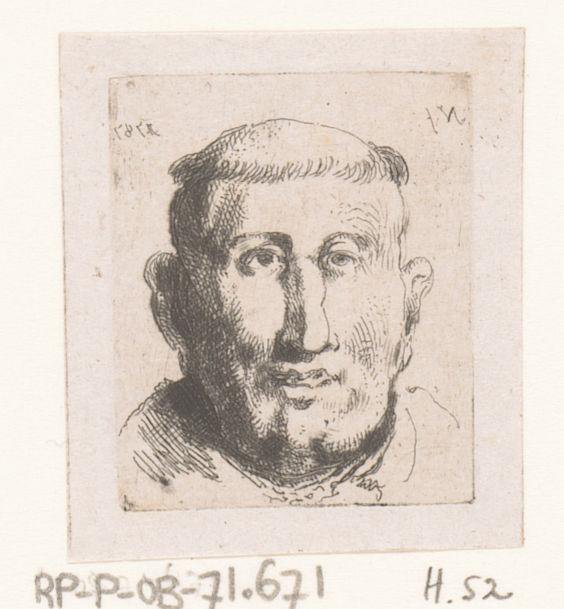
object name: print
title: Kop van een monnik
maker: jean pierre norblin de la gourdaine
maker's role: print maker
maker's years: 1745-1830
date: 1787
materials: paper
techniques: etching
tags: head (human), monk(s), friar(s)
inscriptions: collector's mark: Lugt 2228